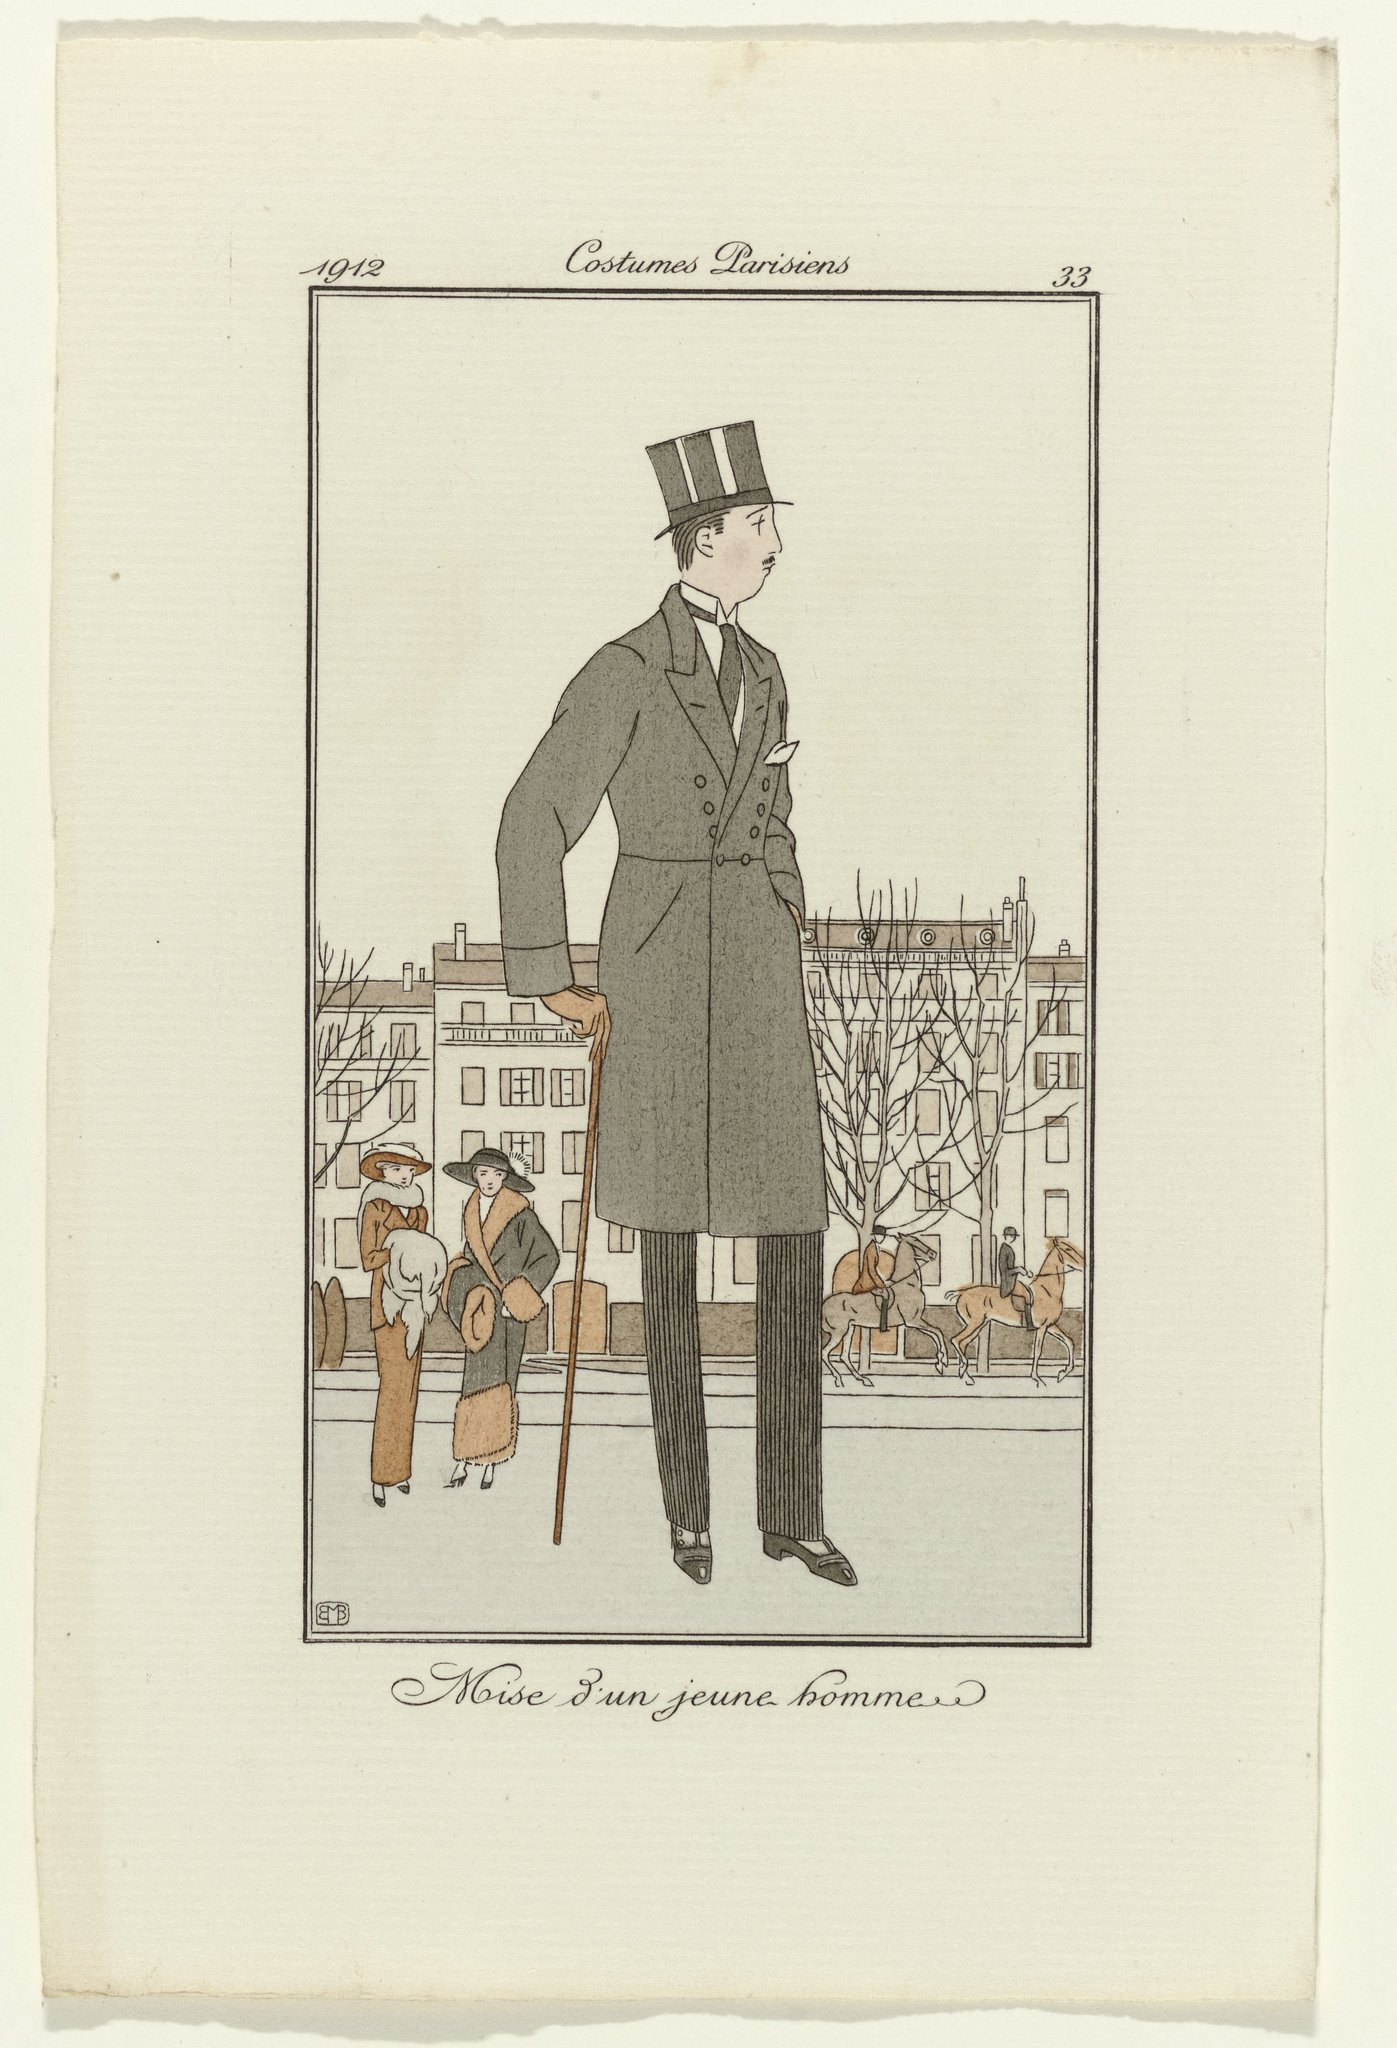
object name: fashion print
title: Journal des Dames et des Modes, 1912, Costumes Parisiens, no. 33: Mise d'un jeune homme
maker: Anonymous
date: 1912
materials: paper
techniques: engraving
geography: paris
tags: fashion plates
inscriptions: caption: ‘Robe de promenade en Sarah à damiers et taffetas peint à la main, bordée de velours noir: Chapeau de paille orné d'un panache en duvet de Cygne’